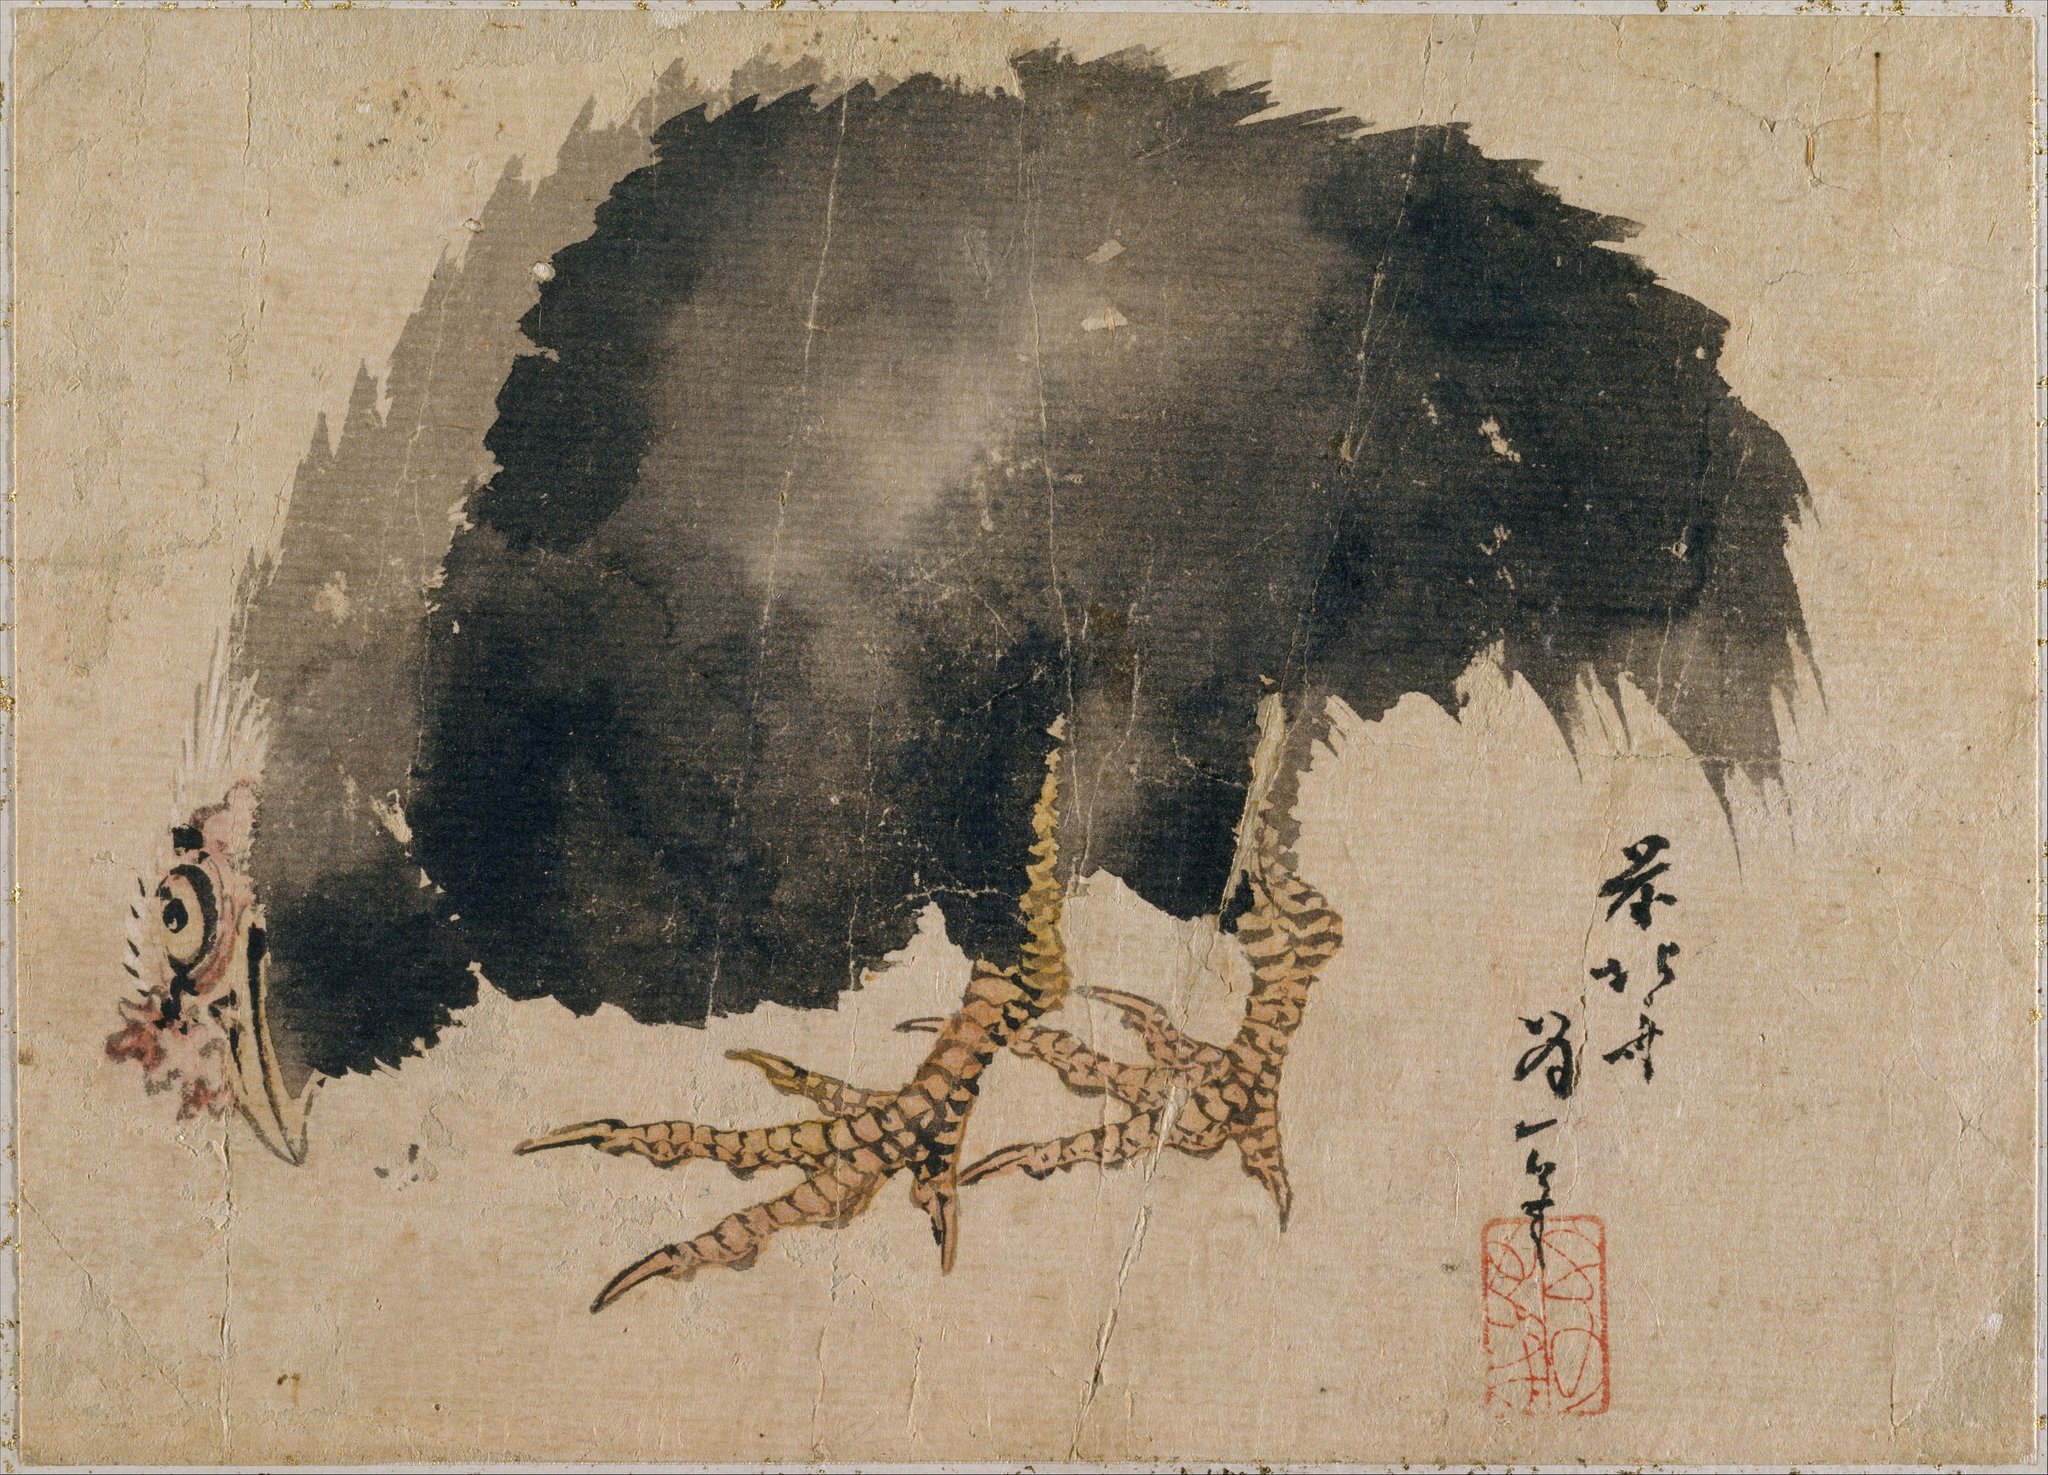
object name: album leaf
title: Album of Sketches by Katsushika Hokusai and His Disciples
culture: japanese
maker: katsushika hokusai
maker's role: artist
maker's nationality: japanese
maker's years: 1760-1849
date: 1801-1900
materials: ink, paper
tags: chickens